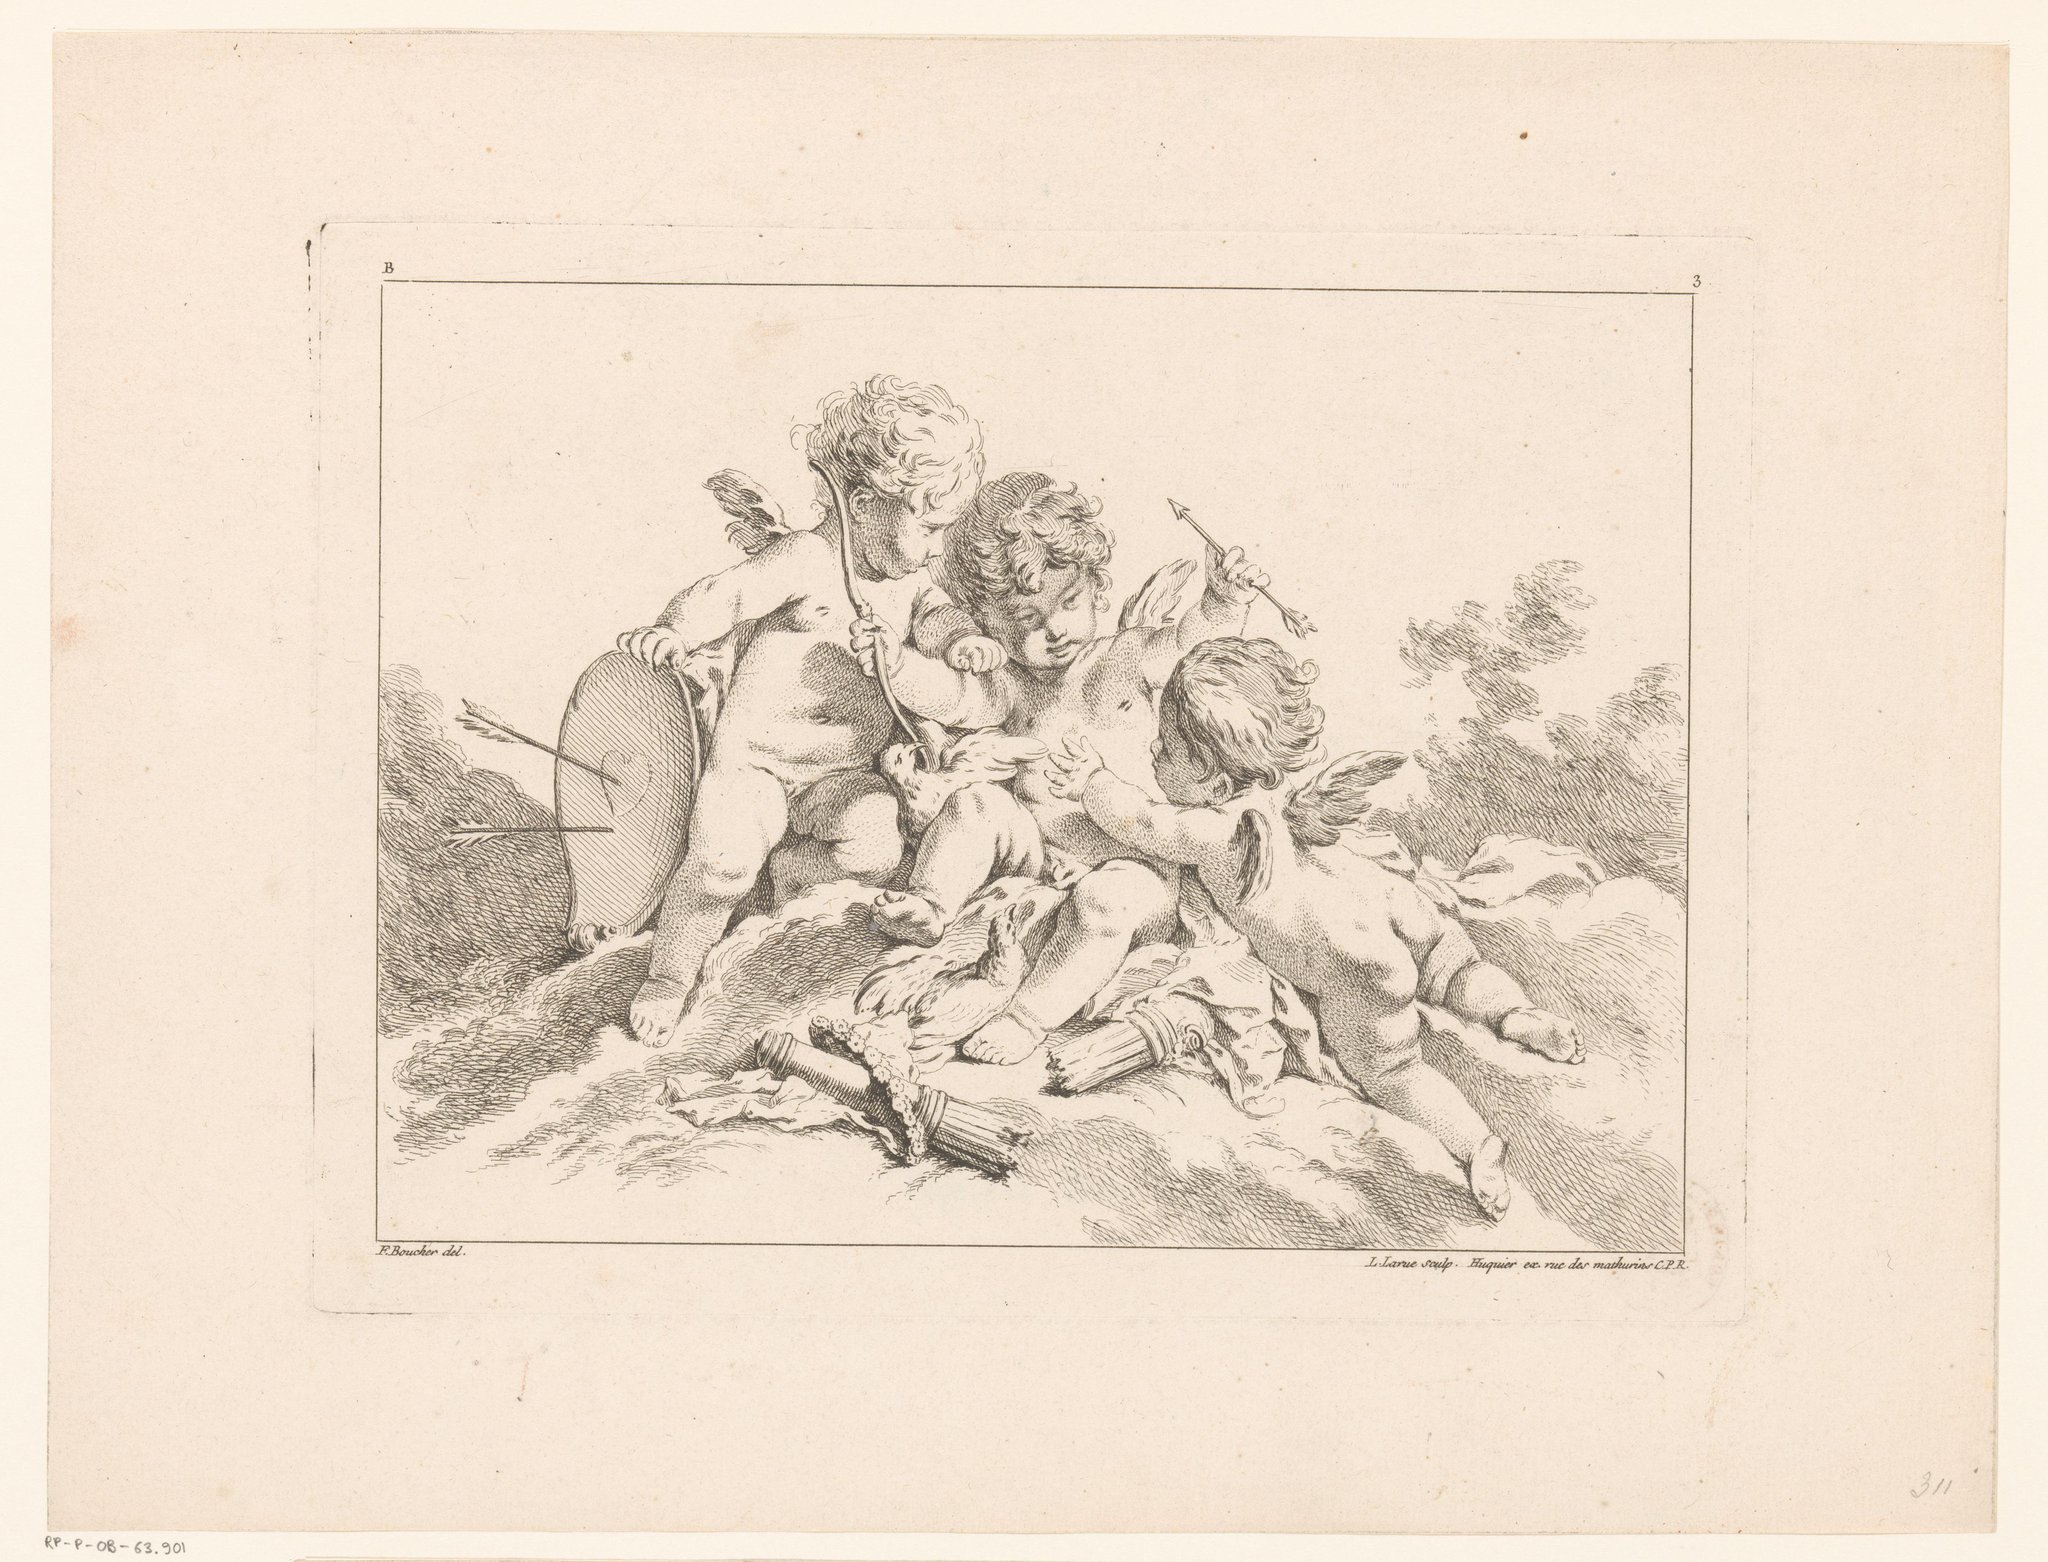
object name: print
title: Drie amors spelend met pijl en boog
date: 1741-1765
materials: paper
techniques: etching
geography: paris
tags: cupids: 'amores', 'amoretti', 'putti'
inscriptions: collector's mark: Lugt 240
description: Maakt mogelijk deel uit van een vierdelige serie met personificaties van de vier elementen met amors.